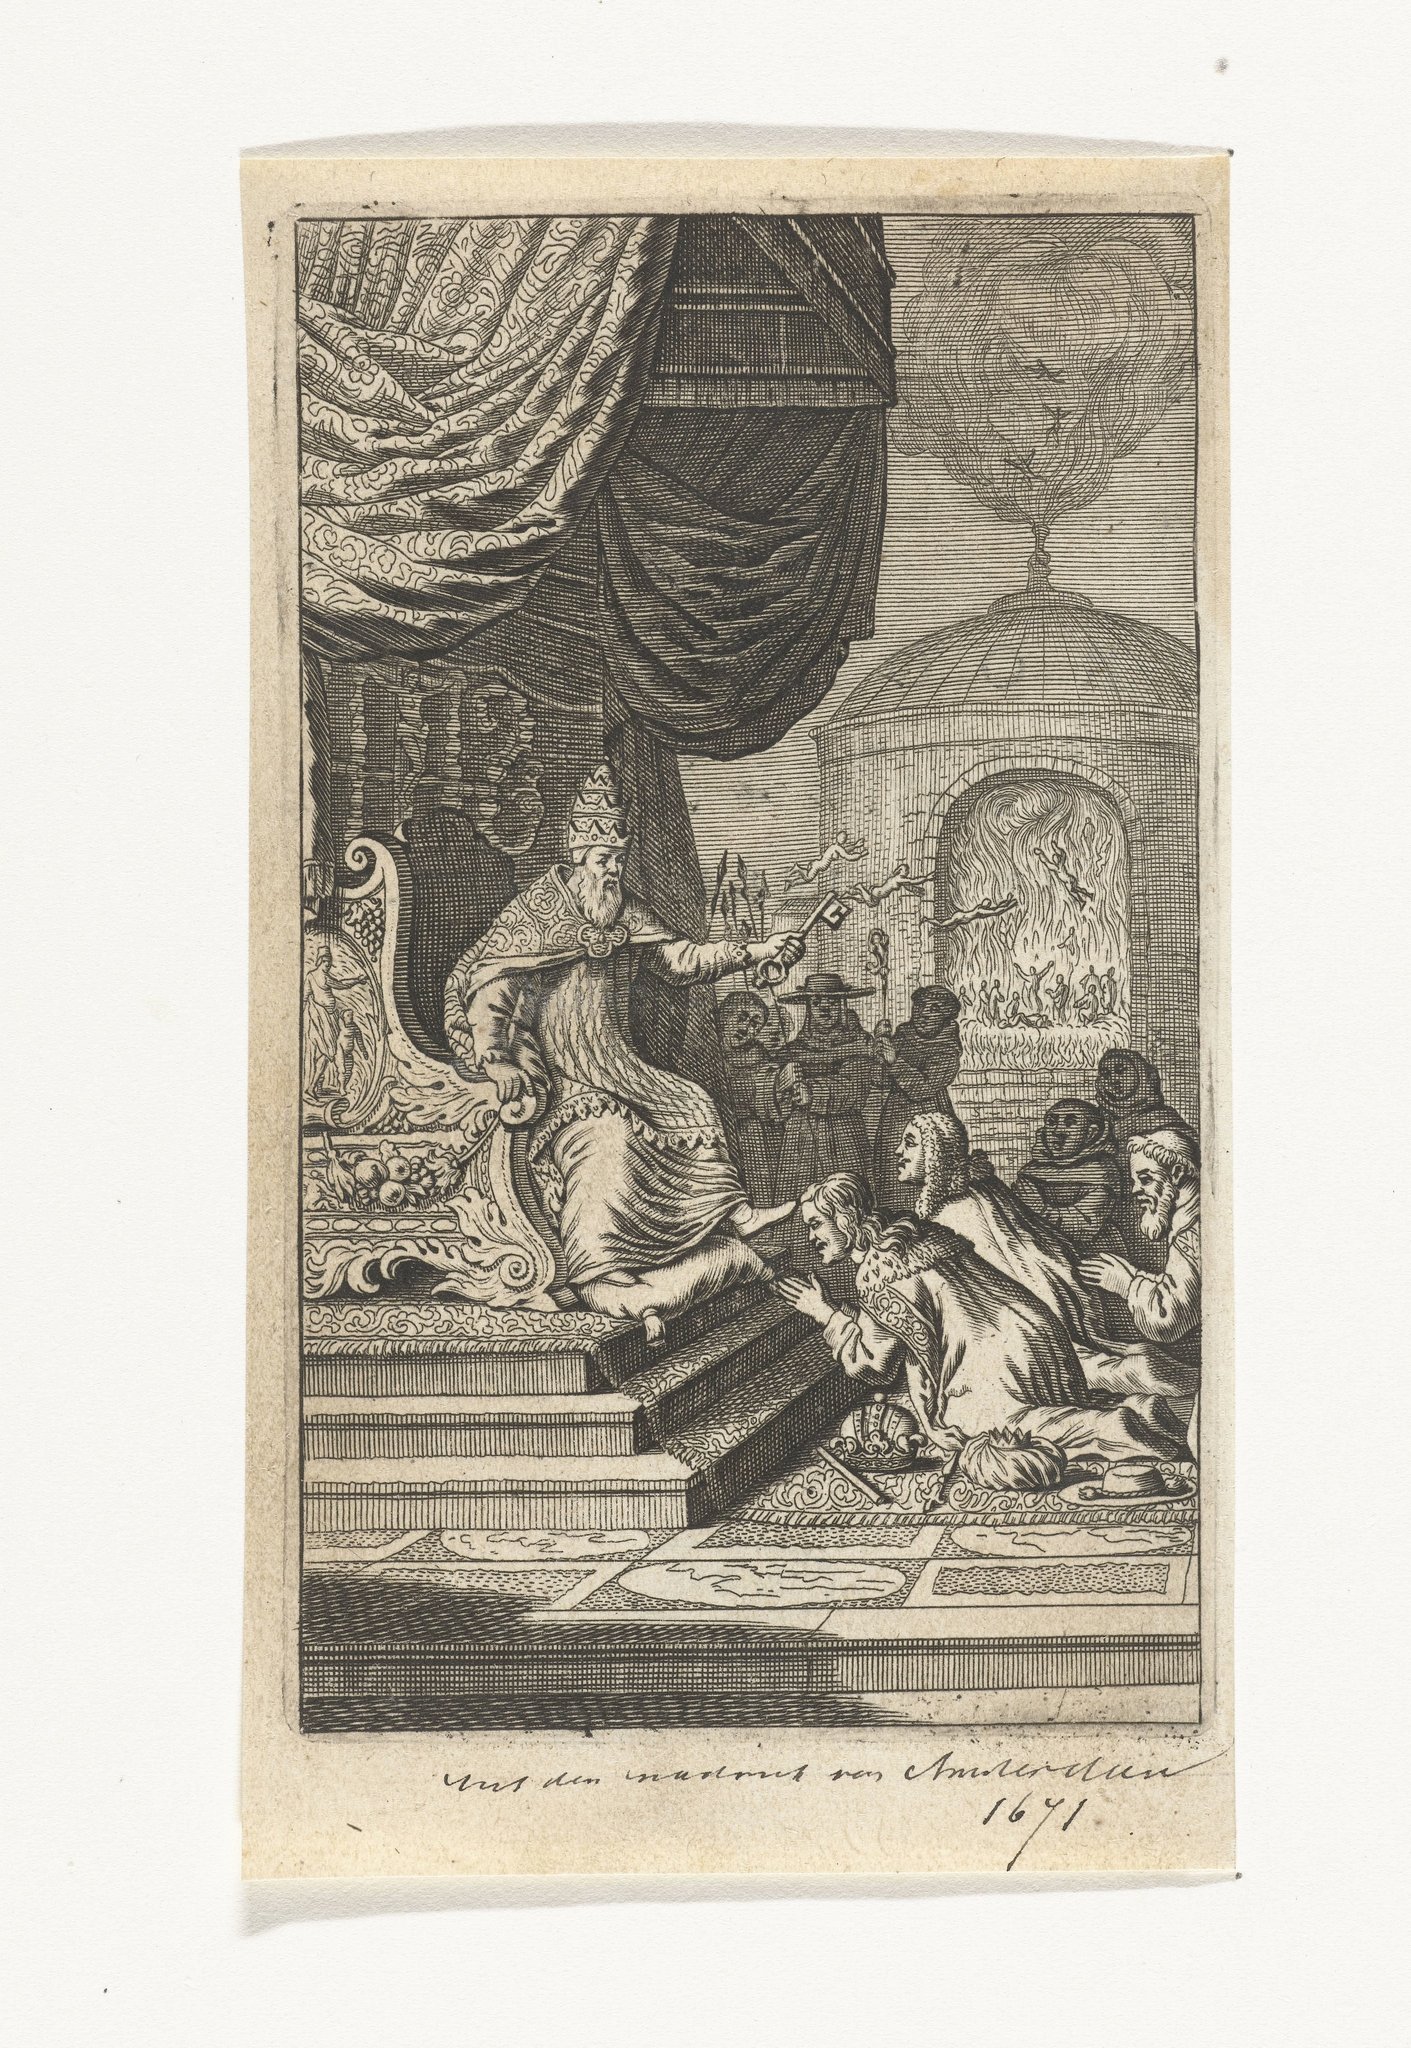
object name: book illustration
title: Wereldlijke vorsten geknield voor de paus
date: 1671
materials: paper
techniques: engraving, etching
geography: amsterdam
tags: fire, oven, furnace ~ interior of industrial structure, pope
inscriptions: inscription: ‘Den Roomschen Uylen-spiegel. Het vierde deel. handelende van den Paus van Romen, onsen heyligen Vader, ende sijne macht over de heylige Schrifture’, inscription: ‘uit den nadruk van Amsterdam 1671’, collector's mark: Lugt 2228a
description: Vorsten en geestelijken knielend voor een paus die zit op een troon. Op de achtergrond een brandende oven met mensen erin. Drie personen lijken naar de oven te vliegen. In de rookwolk die uit de oven komt nog drie lichamen te zien. Achterzijde is het titelblad van het vierde deel van "De Roomsche Uilenspiegel".